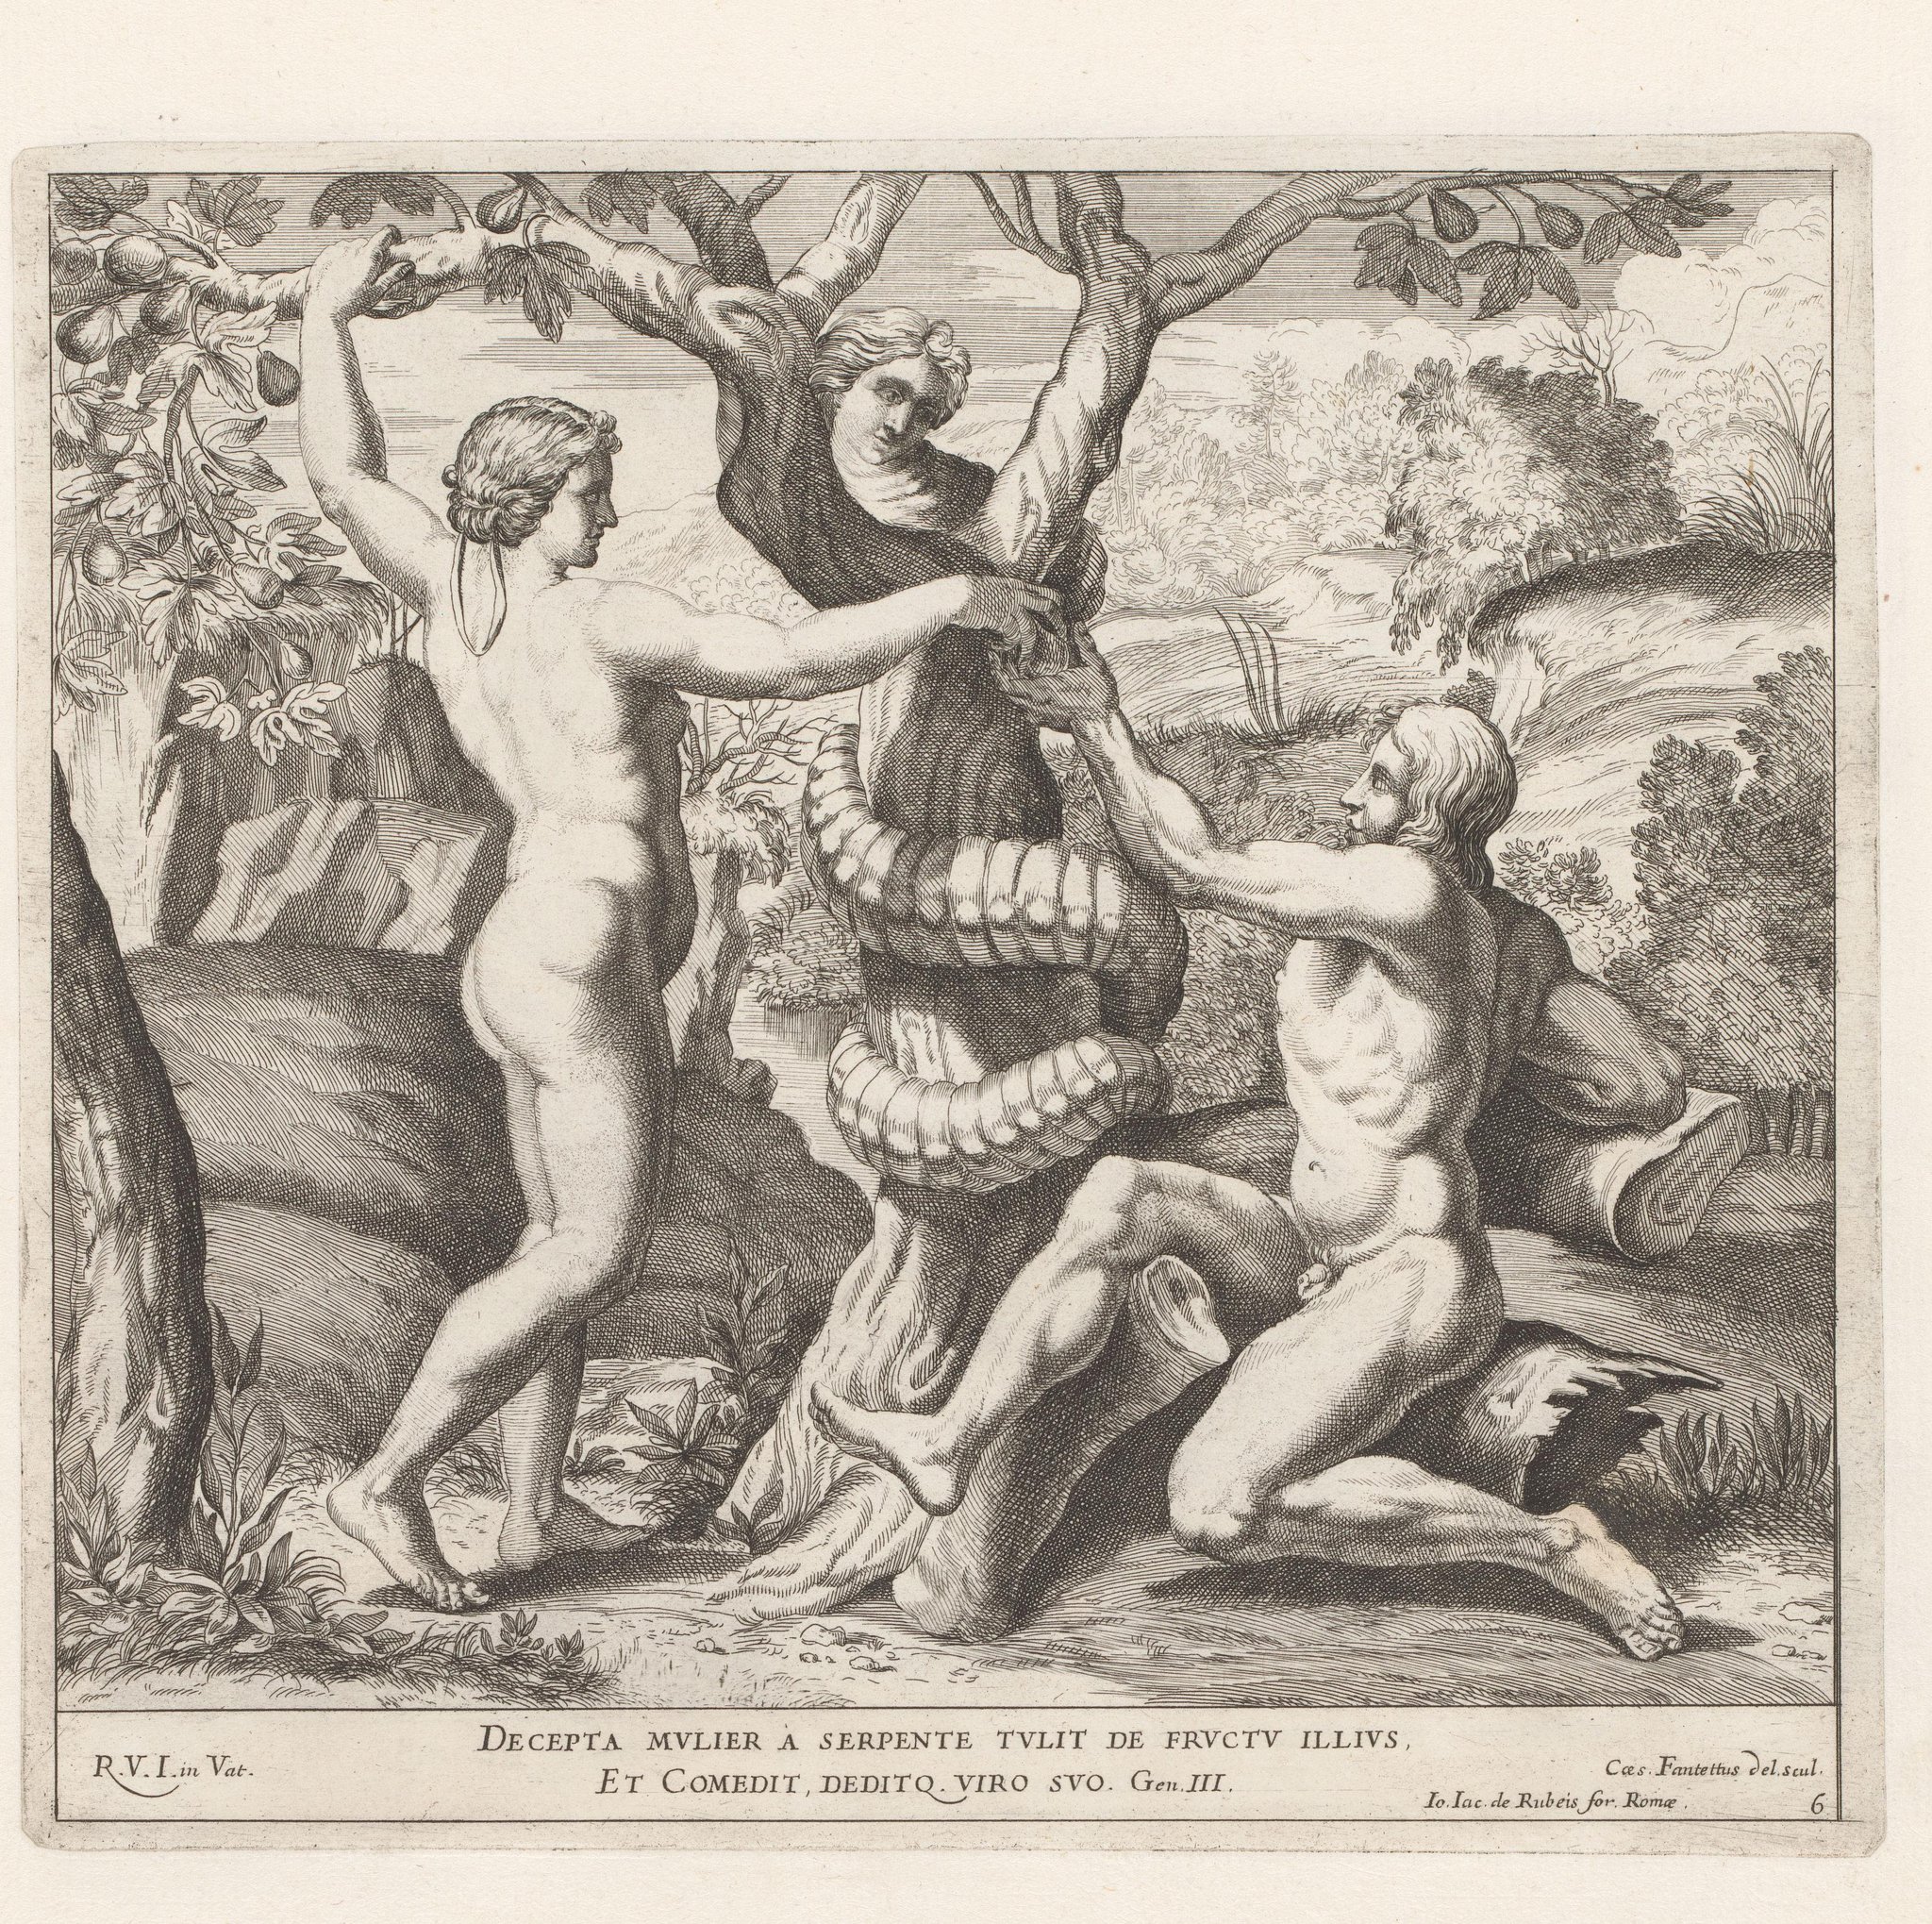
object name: print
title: Imagines Veteris ac Novi Testamenti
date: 1675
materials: paper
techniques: etching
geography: rome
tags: adam and eve holding (and possibly eating) the fruit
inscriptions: number: ‘129’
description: Prent maakt deel uit van een reeks van 55 prenten, bestaande uit drie ongenummerde prenten en een set van 52 genummerde prenten naar de schilderingen in de Loggia van Rafaël.